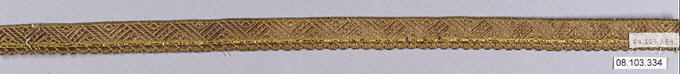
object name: galloon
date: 1801-1900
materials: metal thread